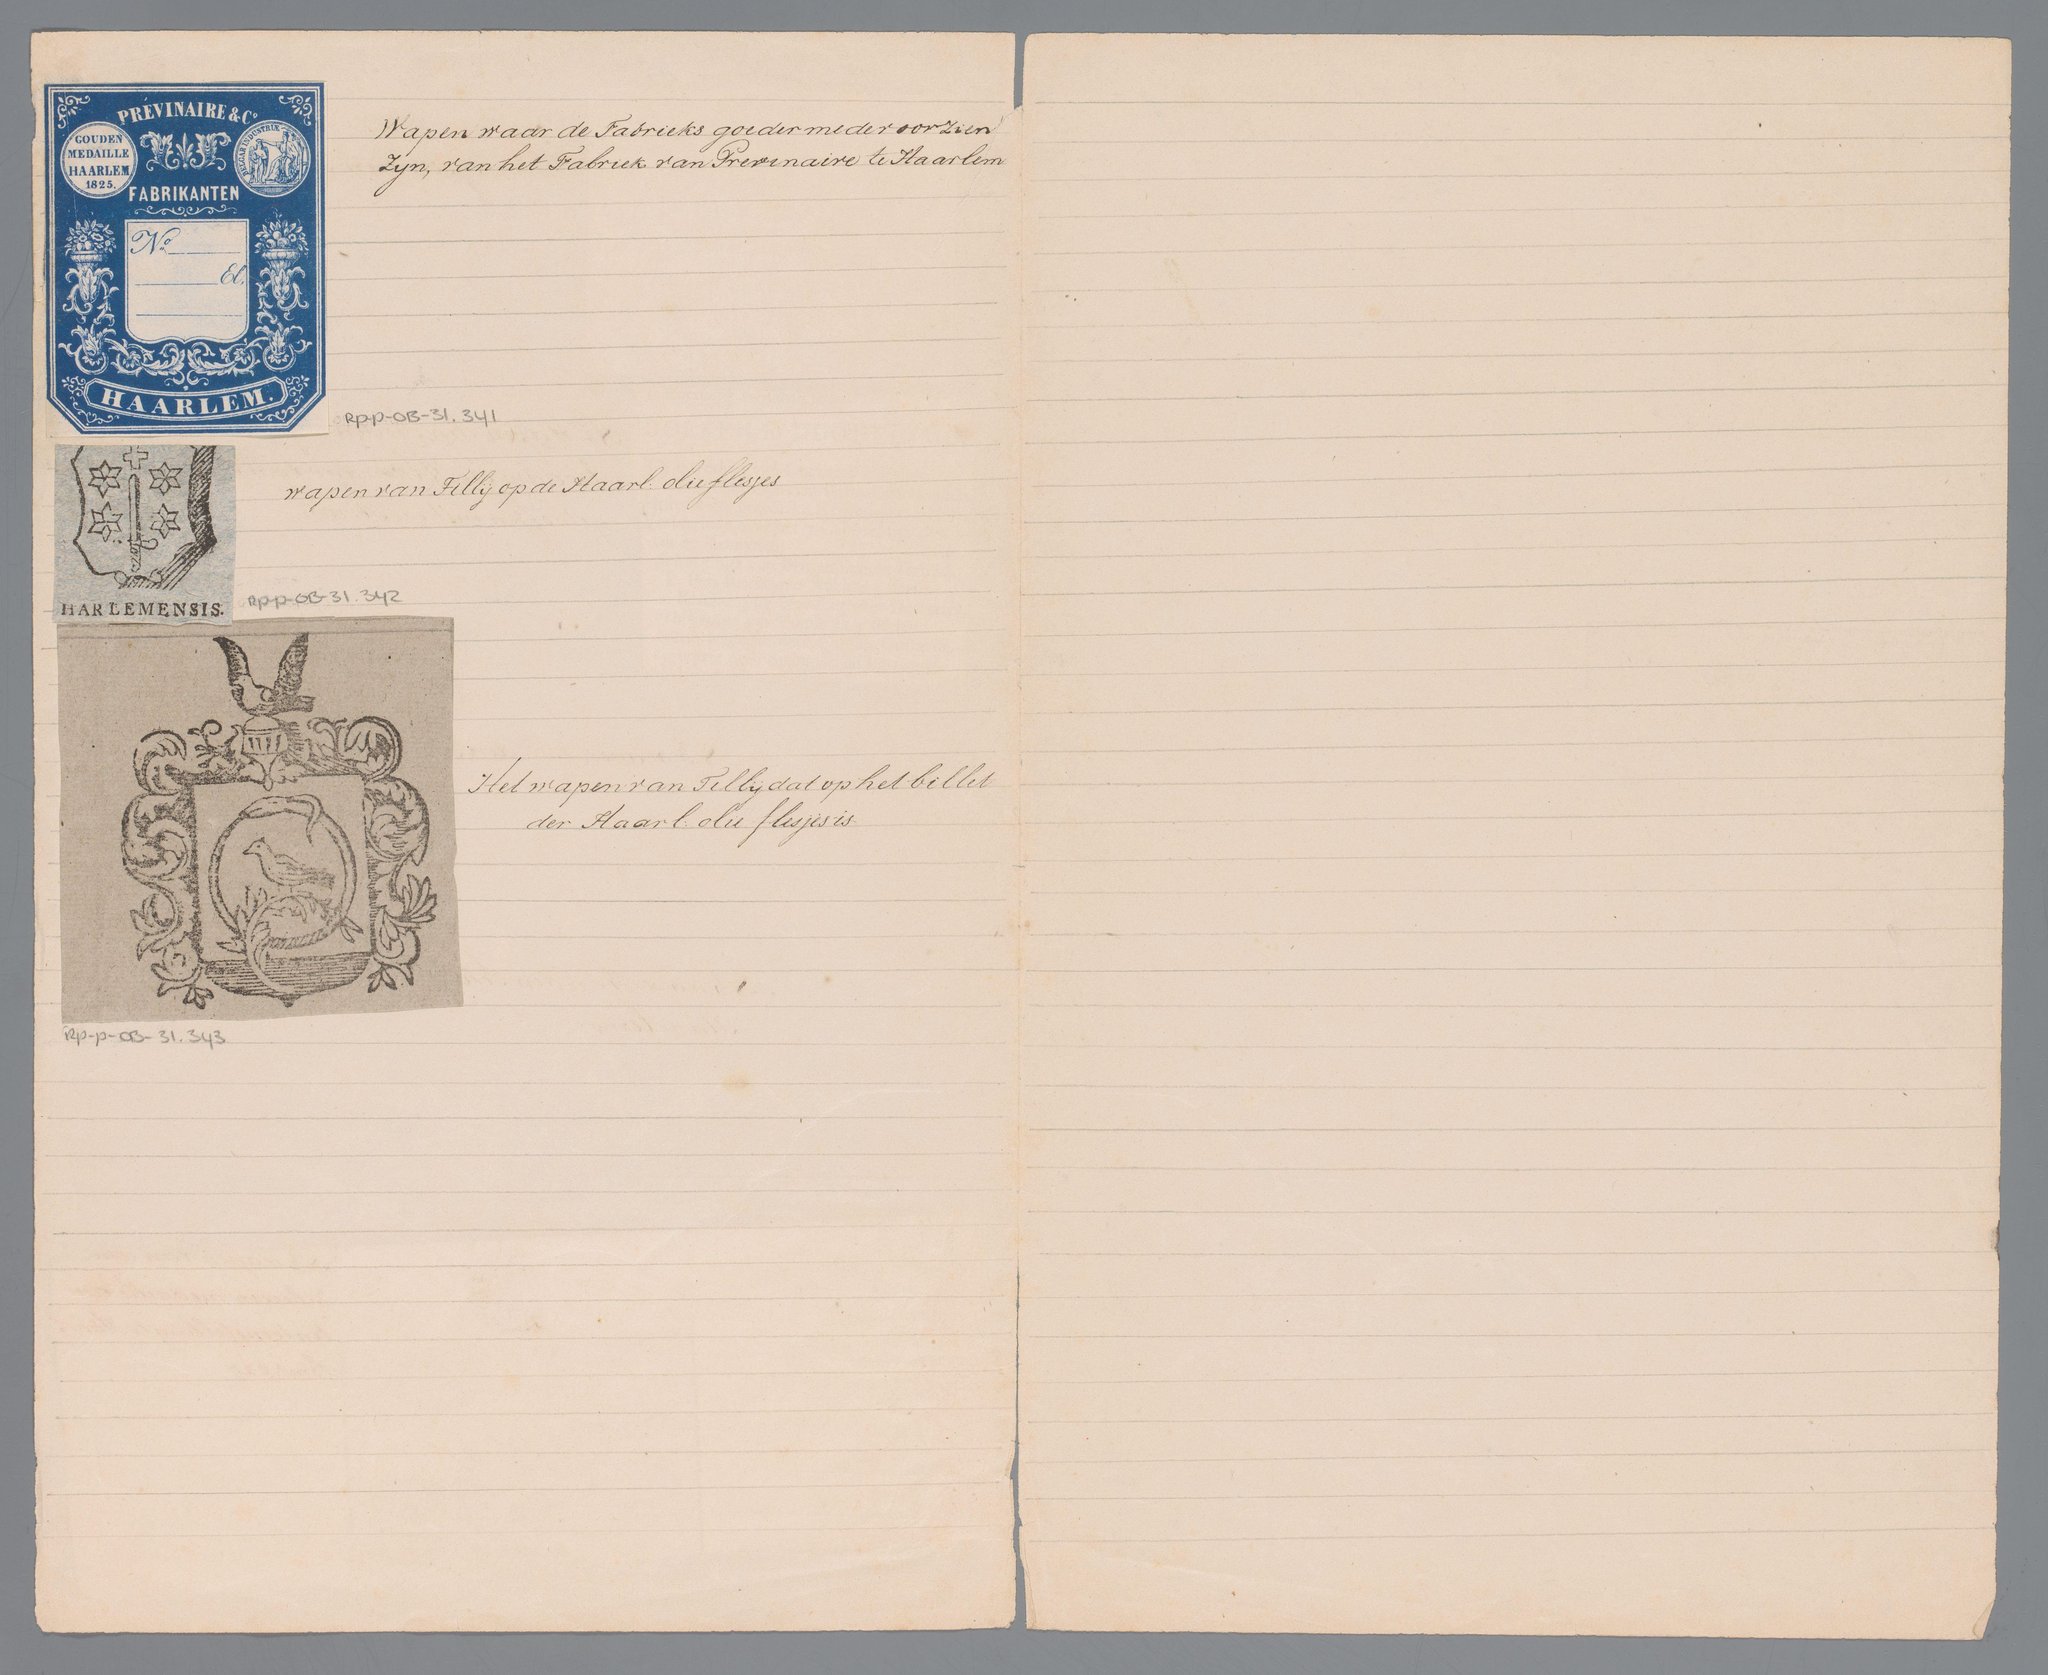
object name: book illustration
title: Vignet met het wapen van C. de Koning Tilly Haarlemmerolie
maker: Anonymous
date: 1700-1799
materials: paper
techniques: letterpress printing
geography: netherlands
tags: coat of arms (as symbol of the state, etc.), snakes, birds, vignette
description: Het wapen van C. de Koning Tilly Haarlemmerolie met daarop een vogel op een tak en een slang.